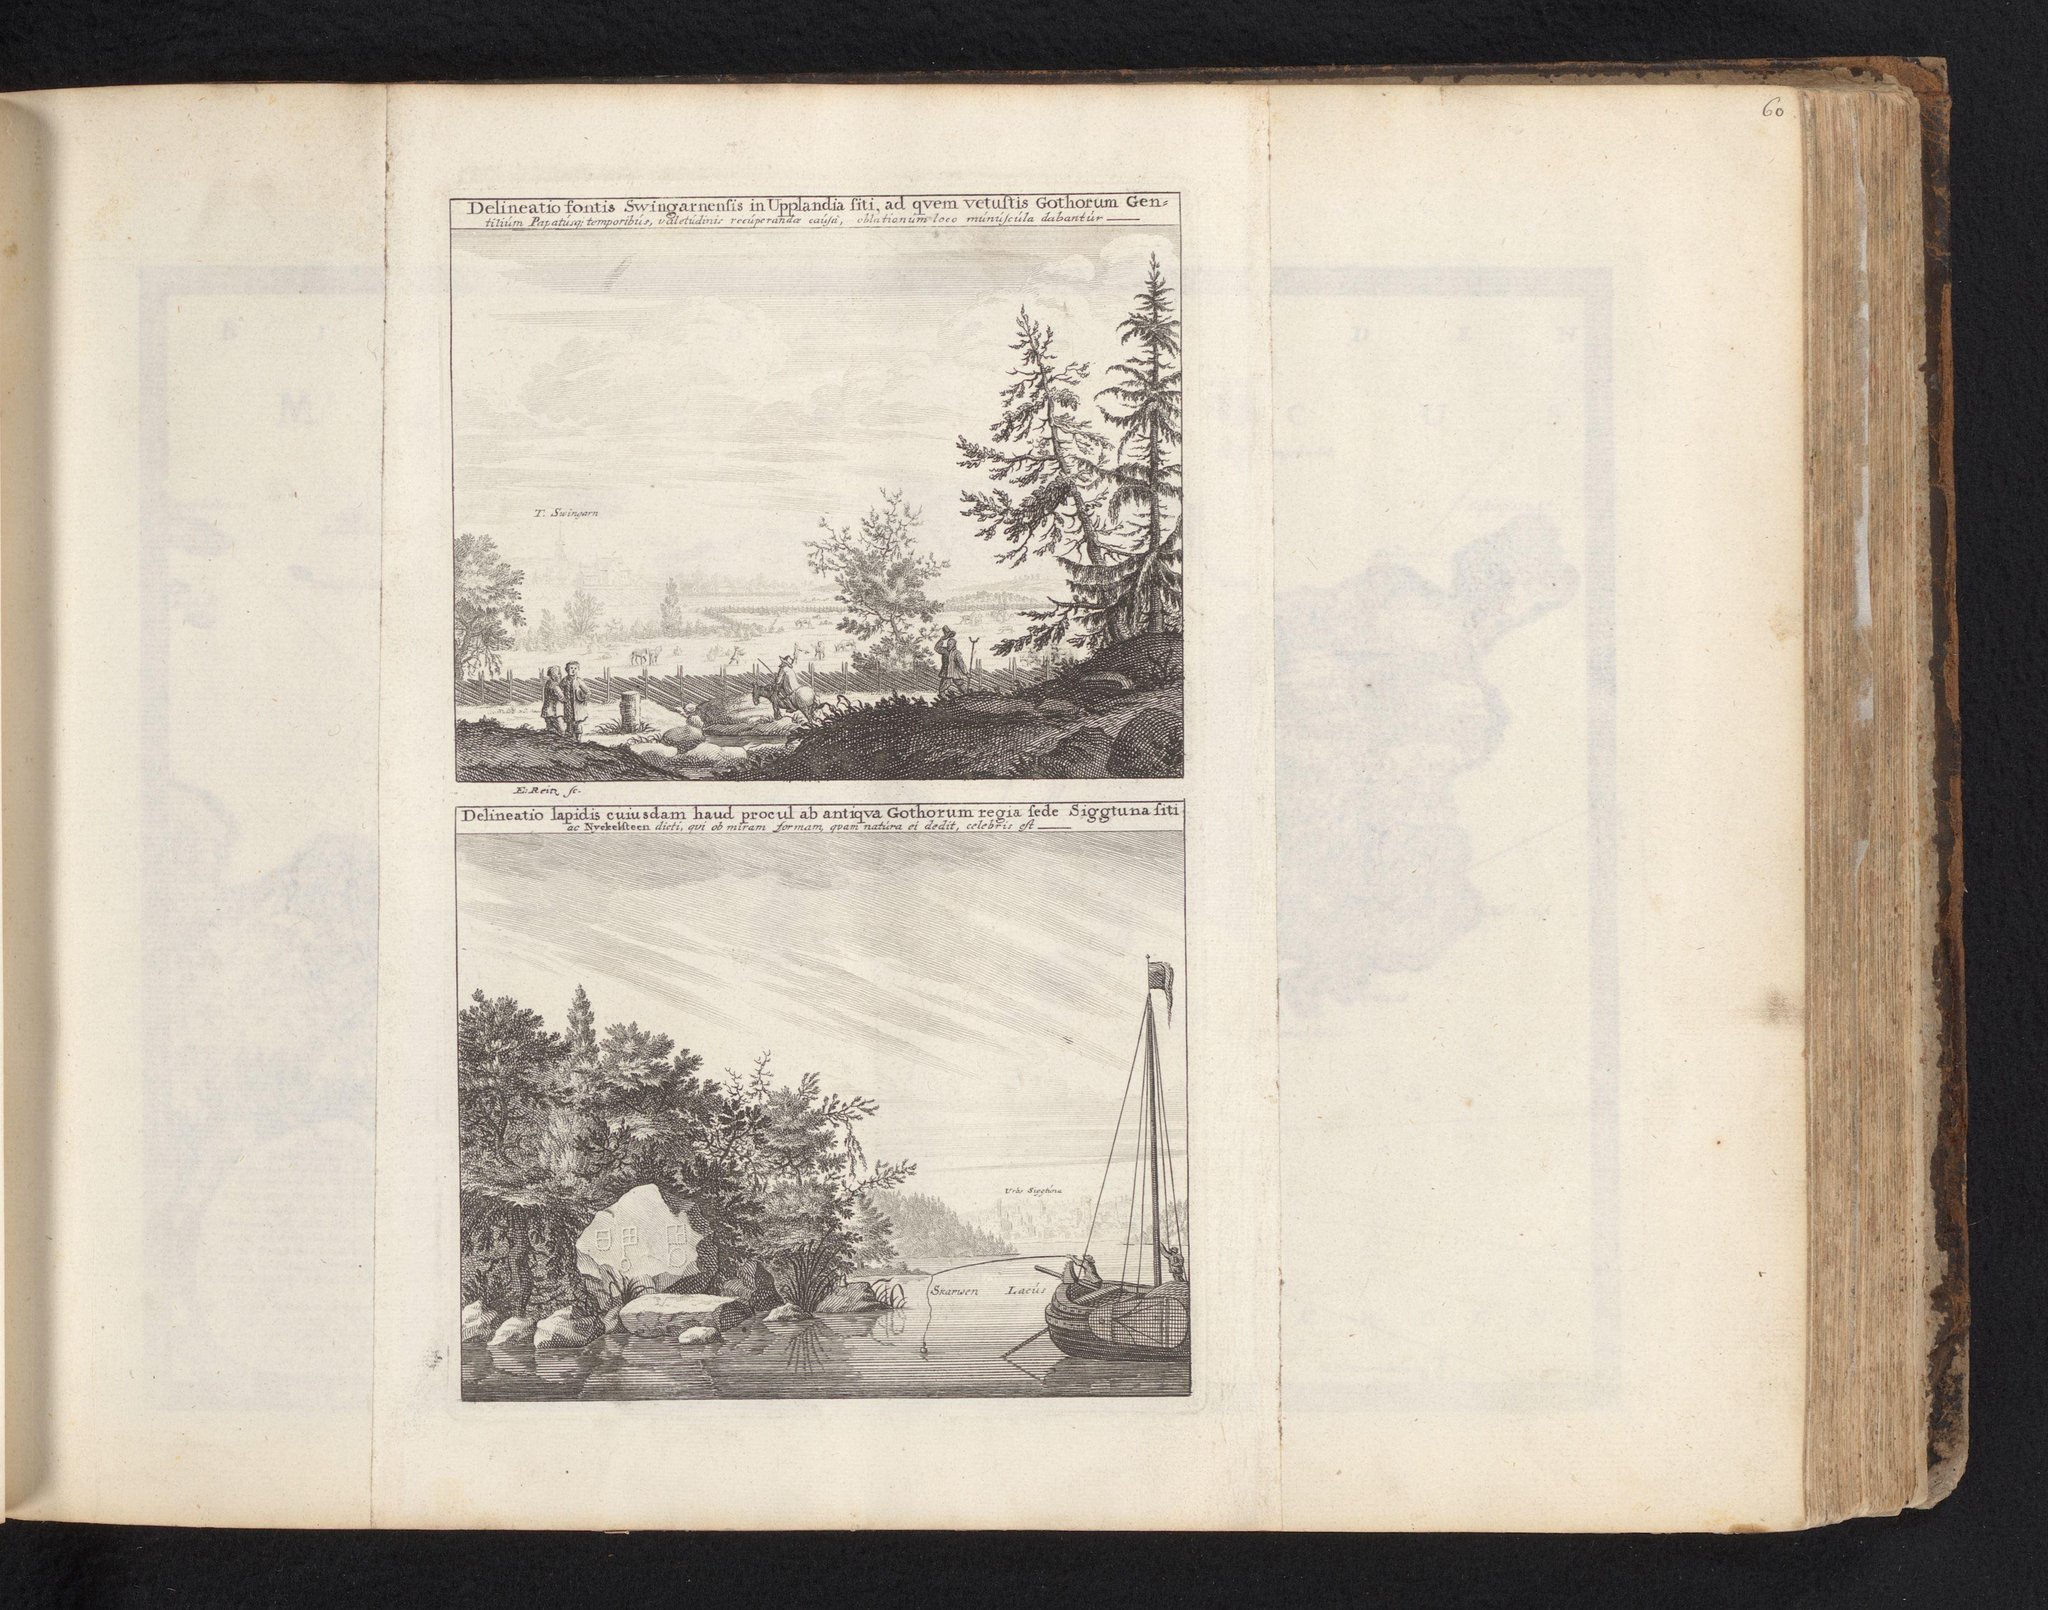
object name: print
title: Bron van Svinngarn en runensteen in Sigtuna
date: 1695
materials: paper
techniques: etching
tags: sigtuna, svinnegarn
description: Kungliga Biblioteket, 'Suecia': http://www.kb.se/samlingarna/Kartor-bilder/Suecia-antiqua/ (geraadpleegd november 2016).